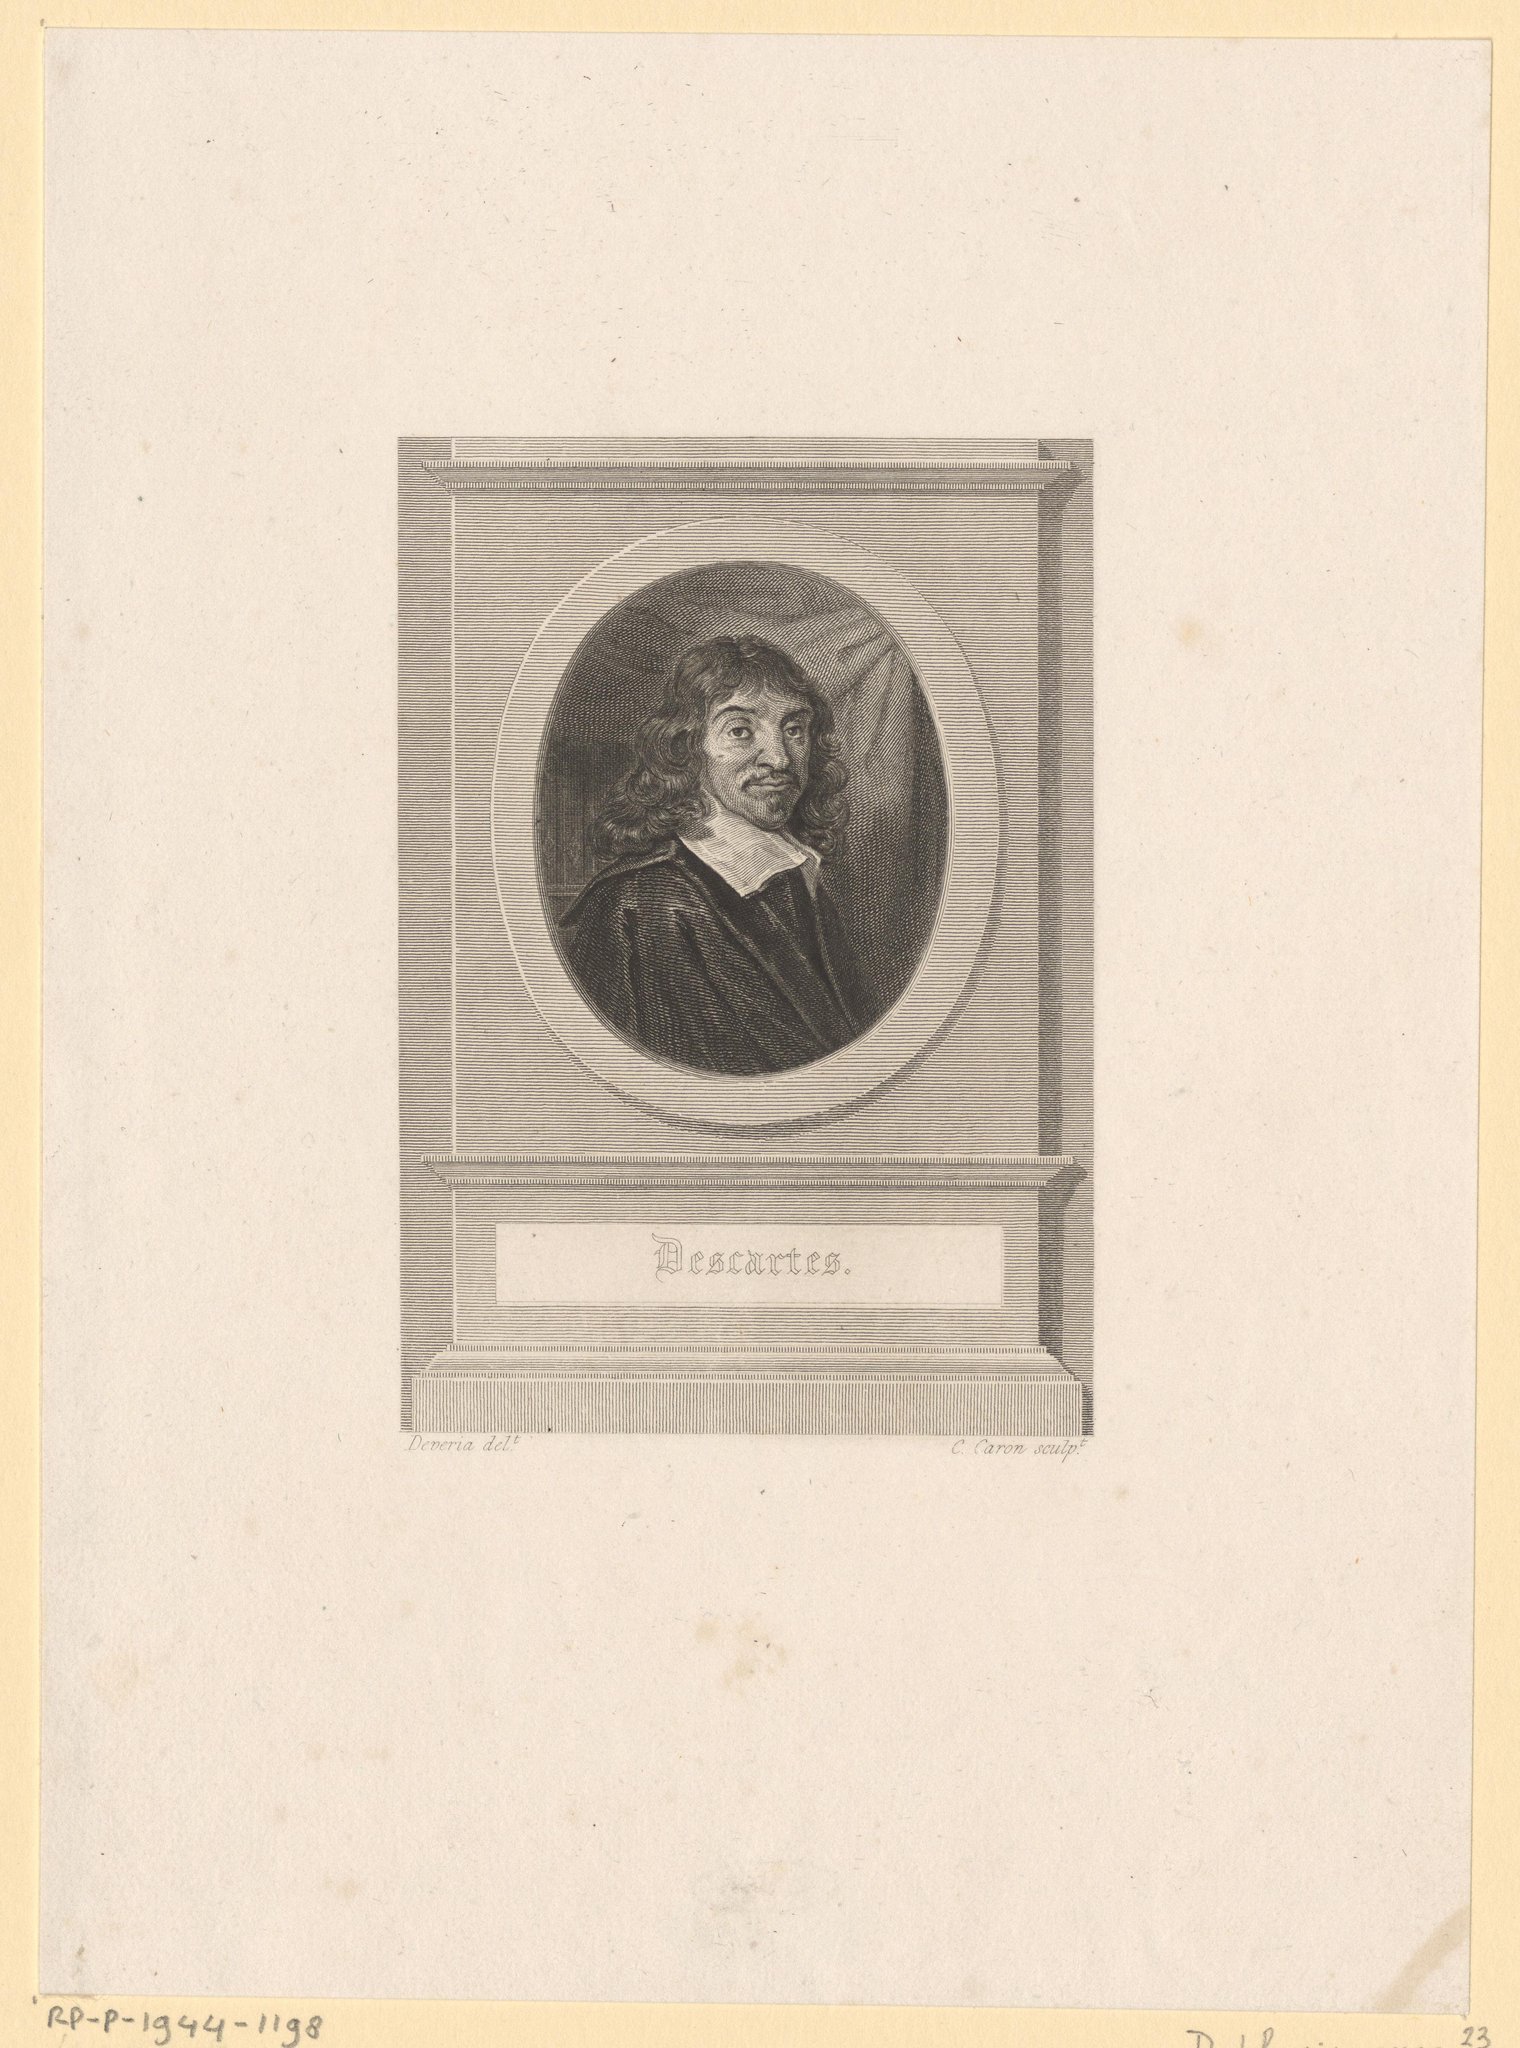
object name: print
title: Portret van René Descartes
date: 1800-1832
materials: paper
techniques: engraving, etching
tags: rené descartes, scholar, philosopher, historical persons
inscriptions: collector's mark: Lugt 2228